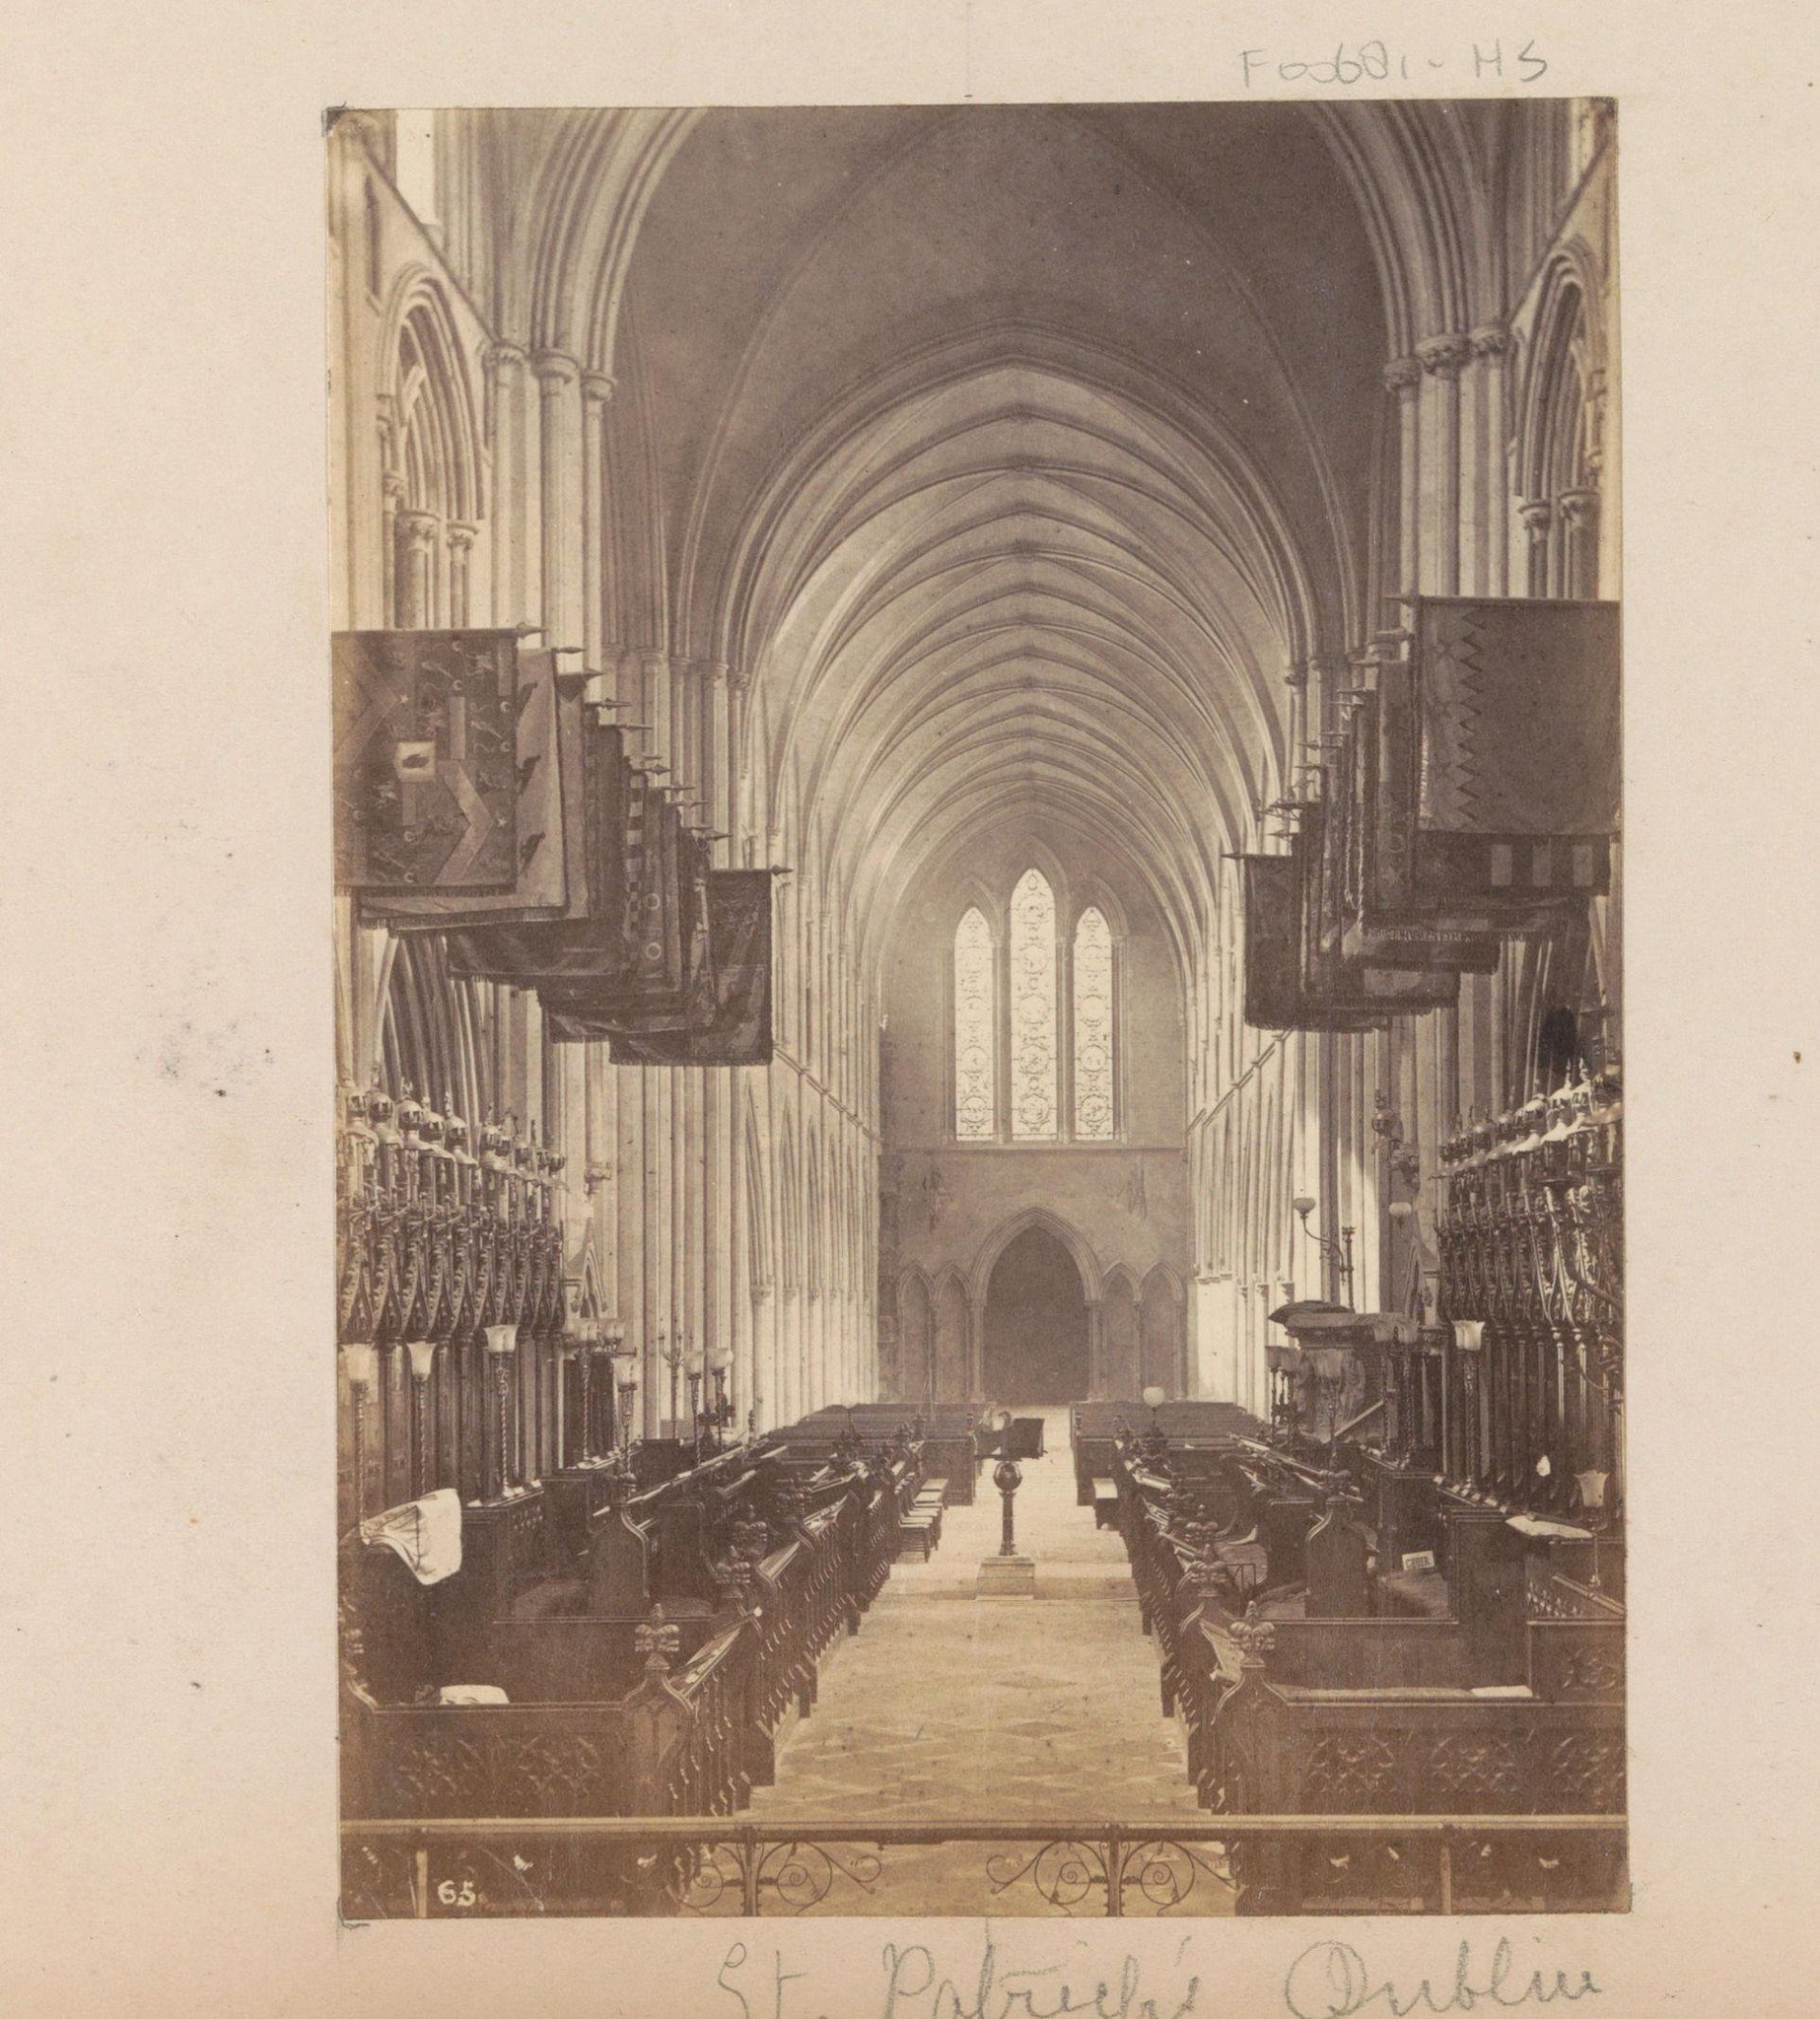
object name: photograph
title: Koor en schip van Saint Patrick's Cathedral in Dublin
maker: Anonymous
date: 1850-1870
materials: paper, photographic support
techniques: albumen print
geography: dublin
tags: parts of church interior: nave, parts of church interior: choir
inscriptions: negative number: ‘65’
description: Onderdeel van Album met foto's van bezienswaardigheden en landschappen in Engeland en van kunst.